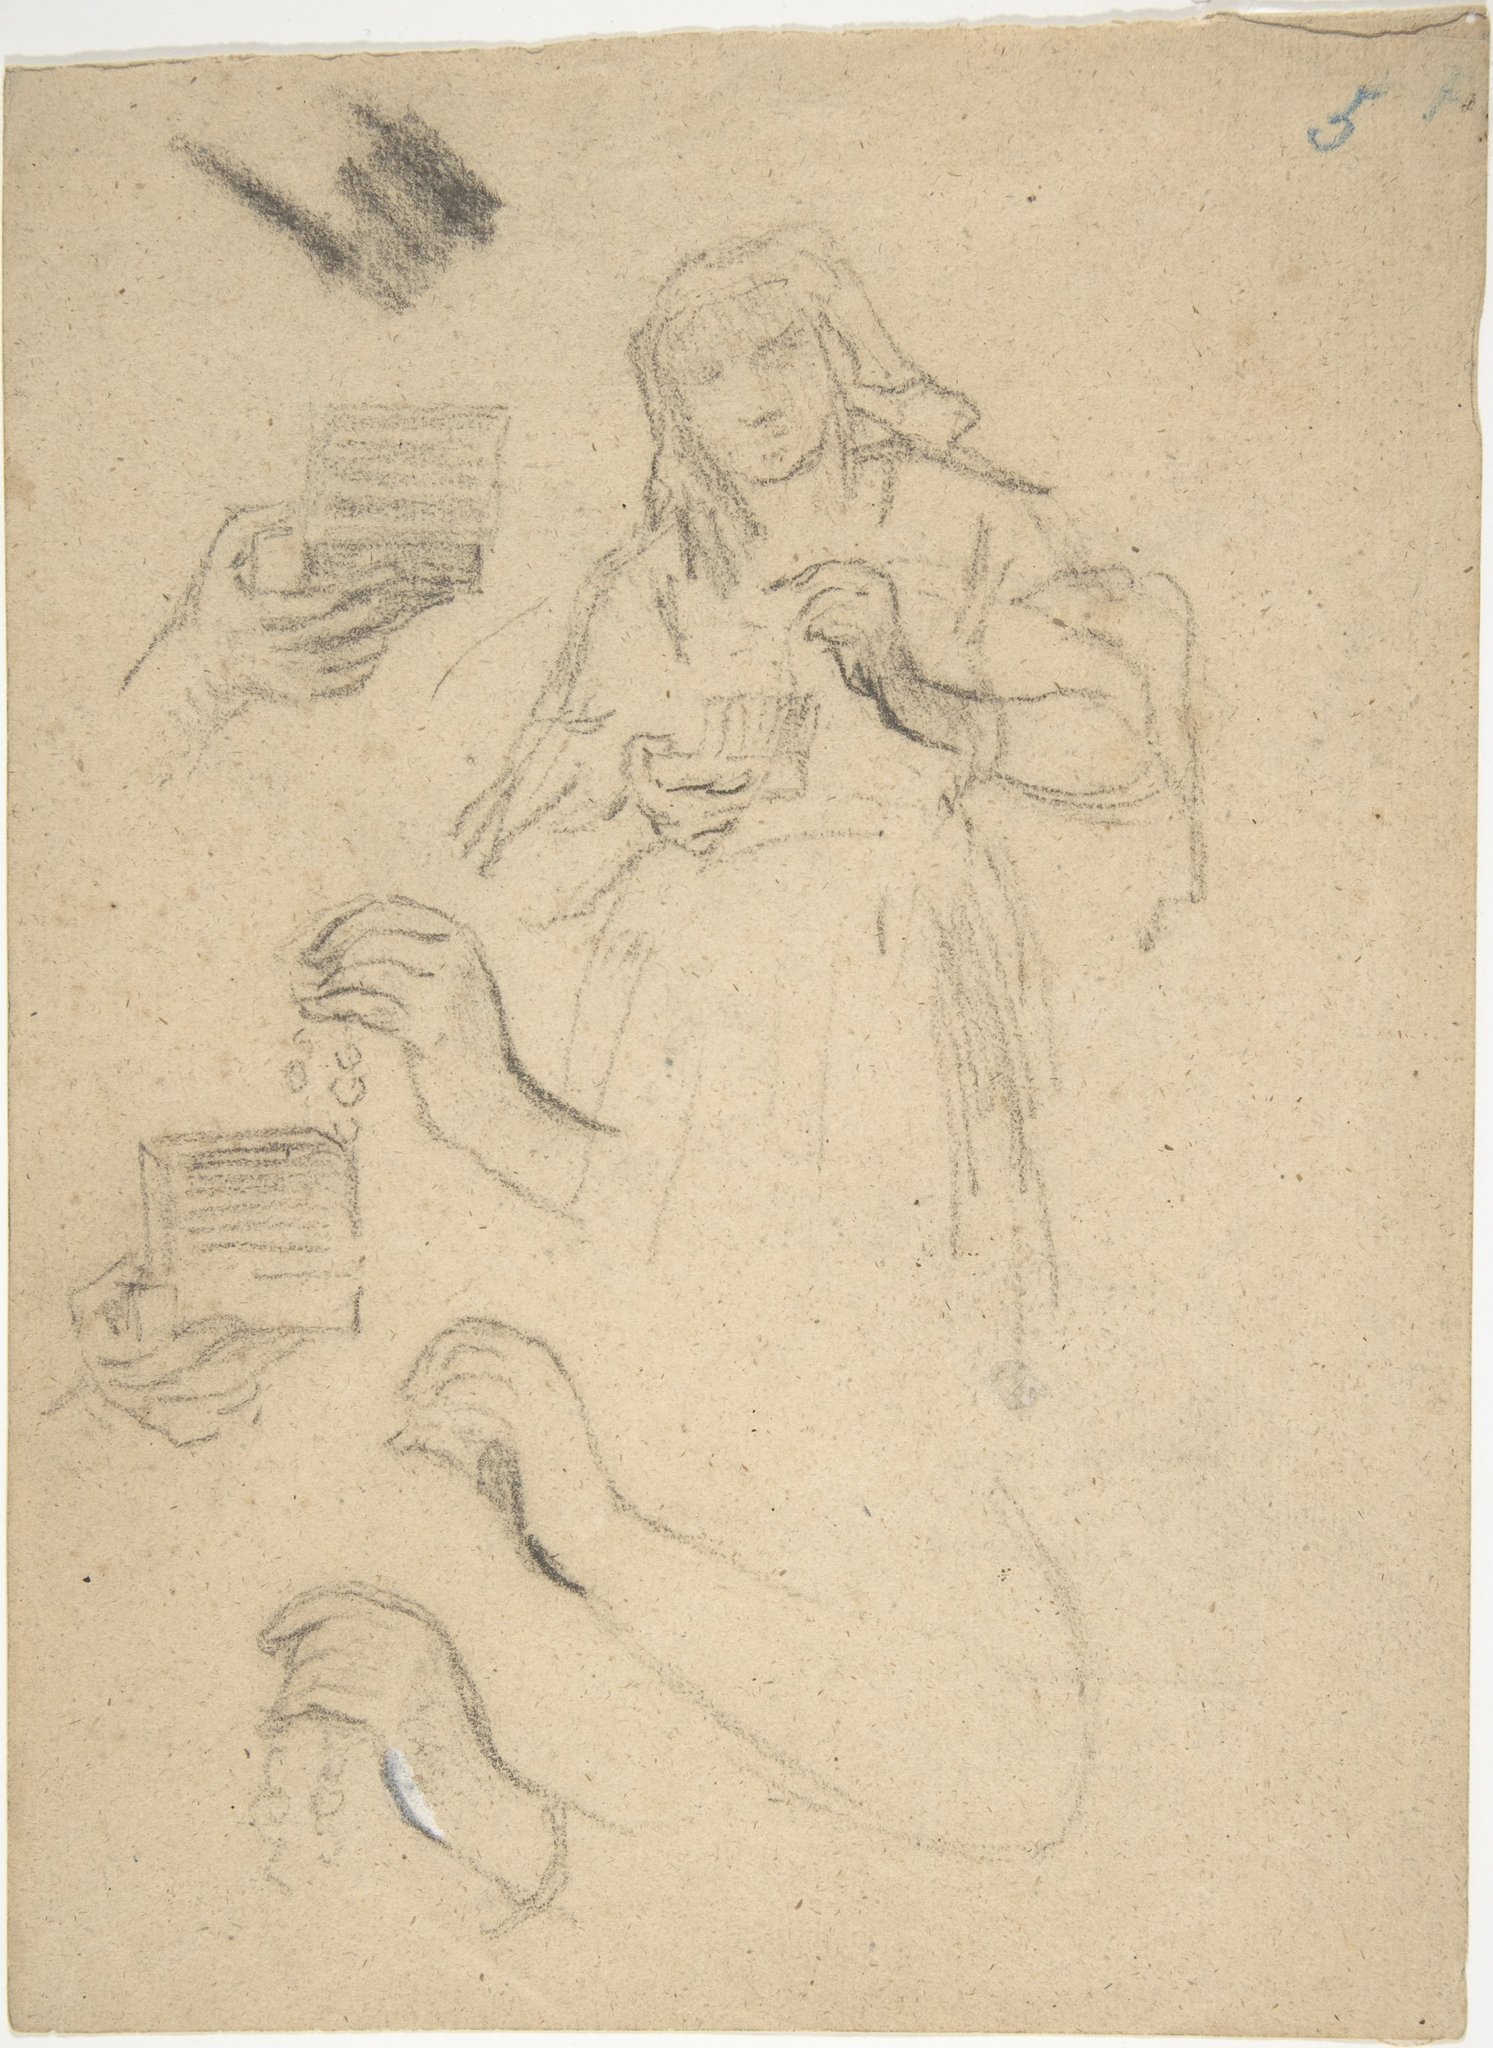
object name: drawing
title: Woman holding an open jewelry box (recto); Studies for a figure composition and a leaded window (verso)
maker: narcisse-virgile diaz de la peña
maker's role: artist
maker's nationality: french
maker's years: 1808-1876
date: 1820-1876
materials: chalk, graphite, paper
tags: hands,women